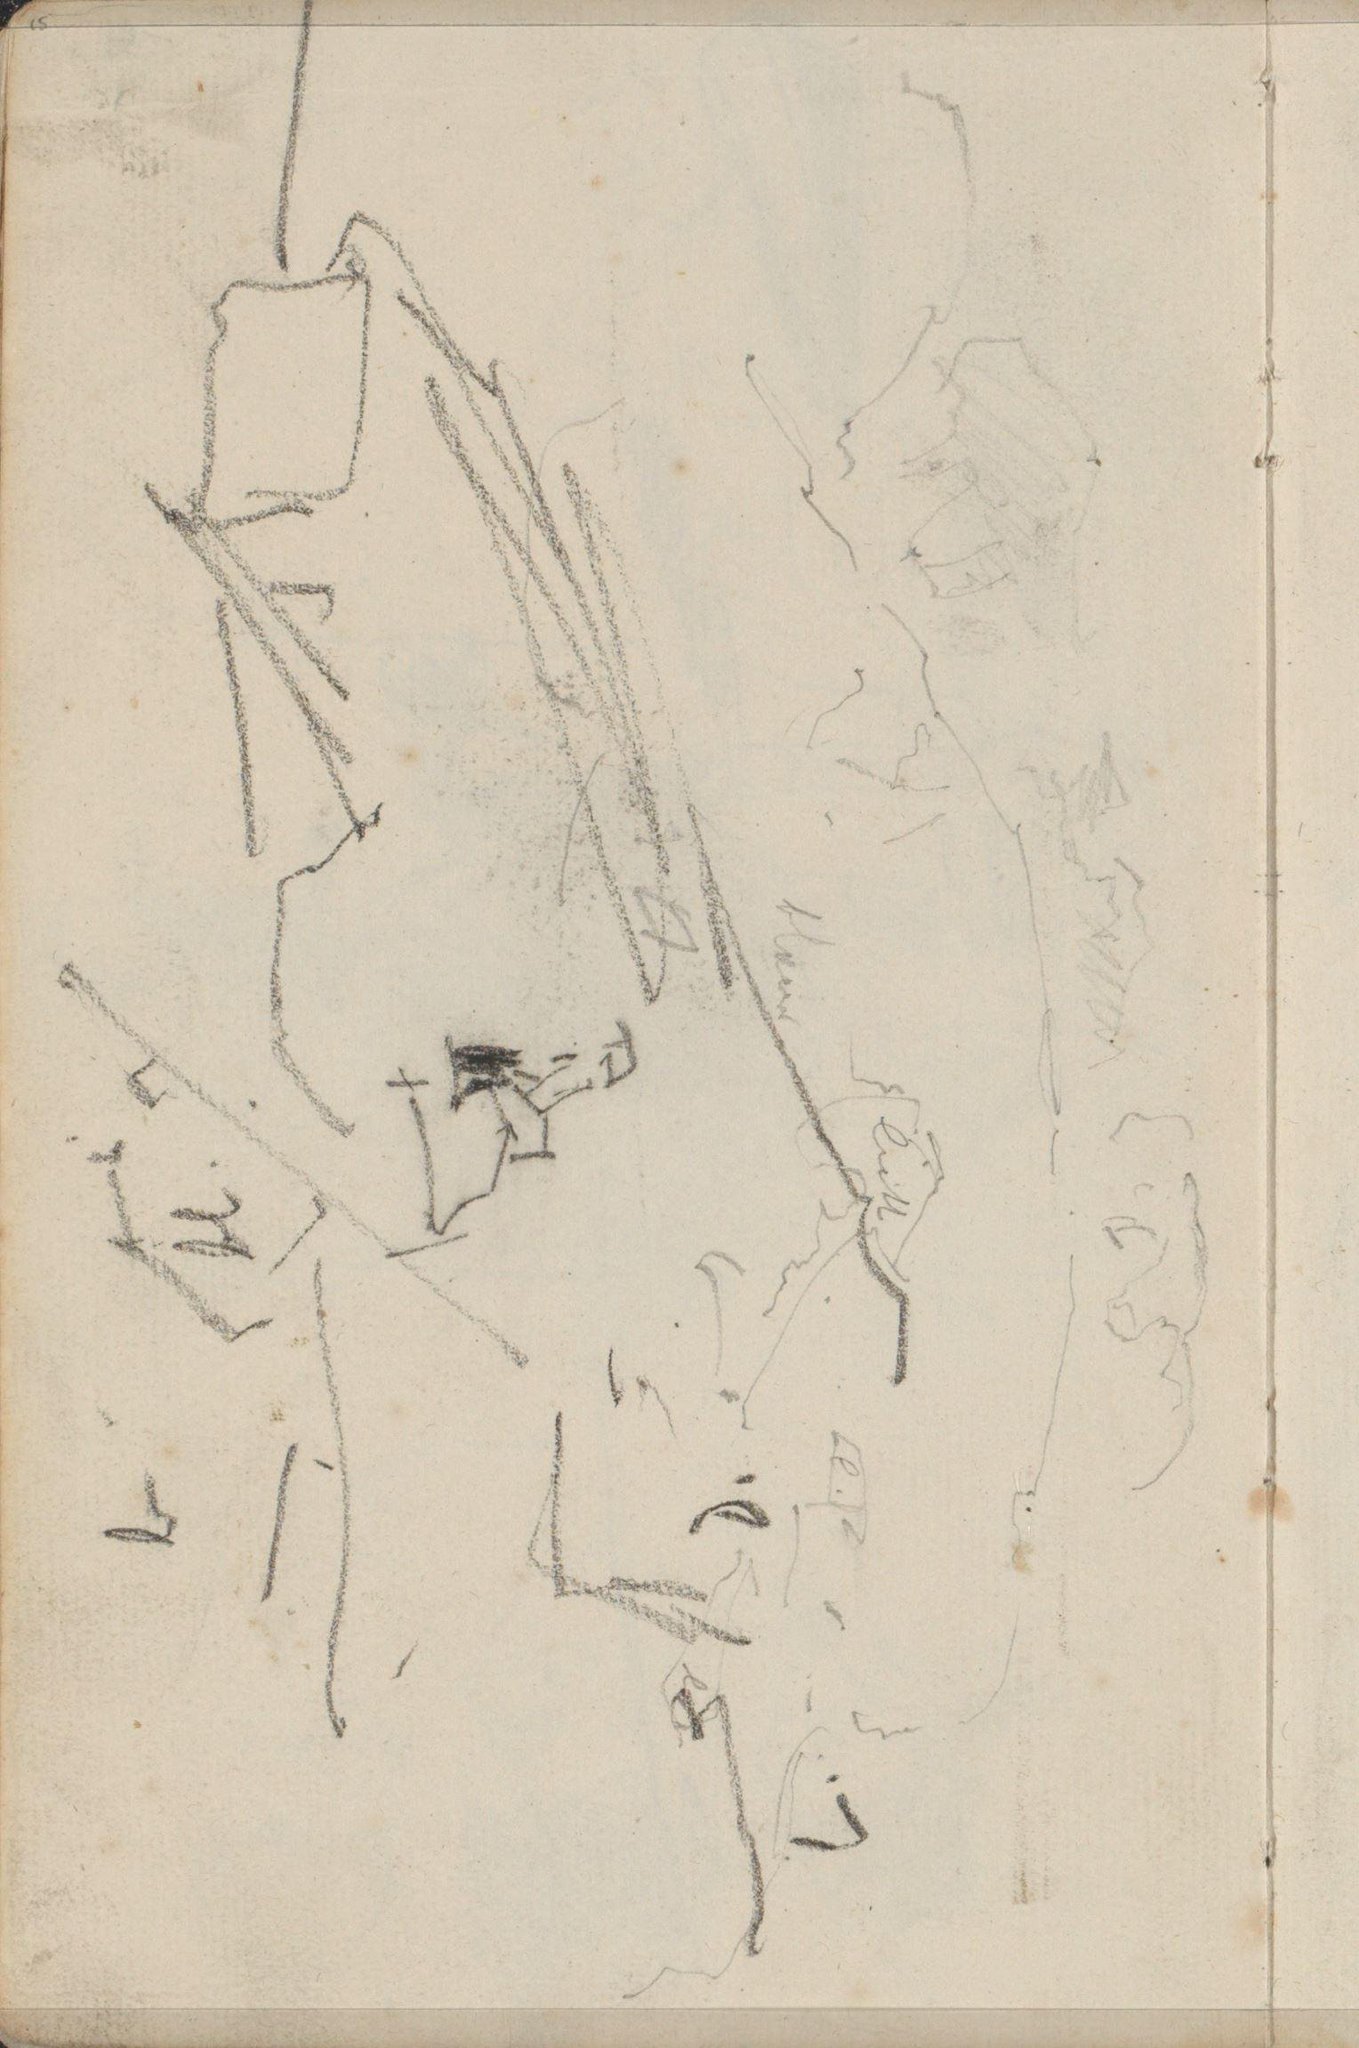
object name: sketchbook leaf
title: Studie, mogelijk van een landschap met bebouwing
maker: george hendrik breitner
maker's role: draughtsman, painter, print maker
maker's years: 1857-1923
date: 1880-1882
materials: chalk, paper, pencil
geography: the hague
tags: landscapes, civic architecture; edifices; dwellings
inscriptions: kleurnotitie, handgeschreven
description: Pagina 15 uit een schetsboek met 23 bladen.